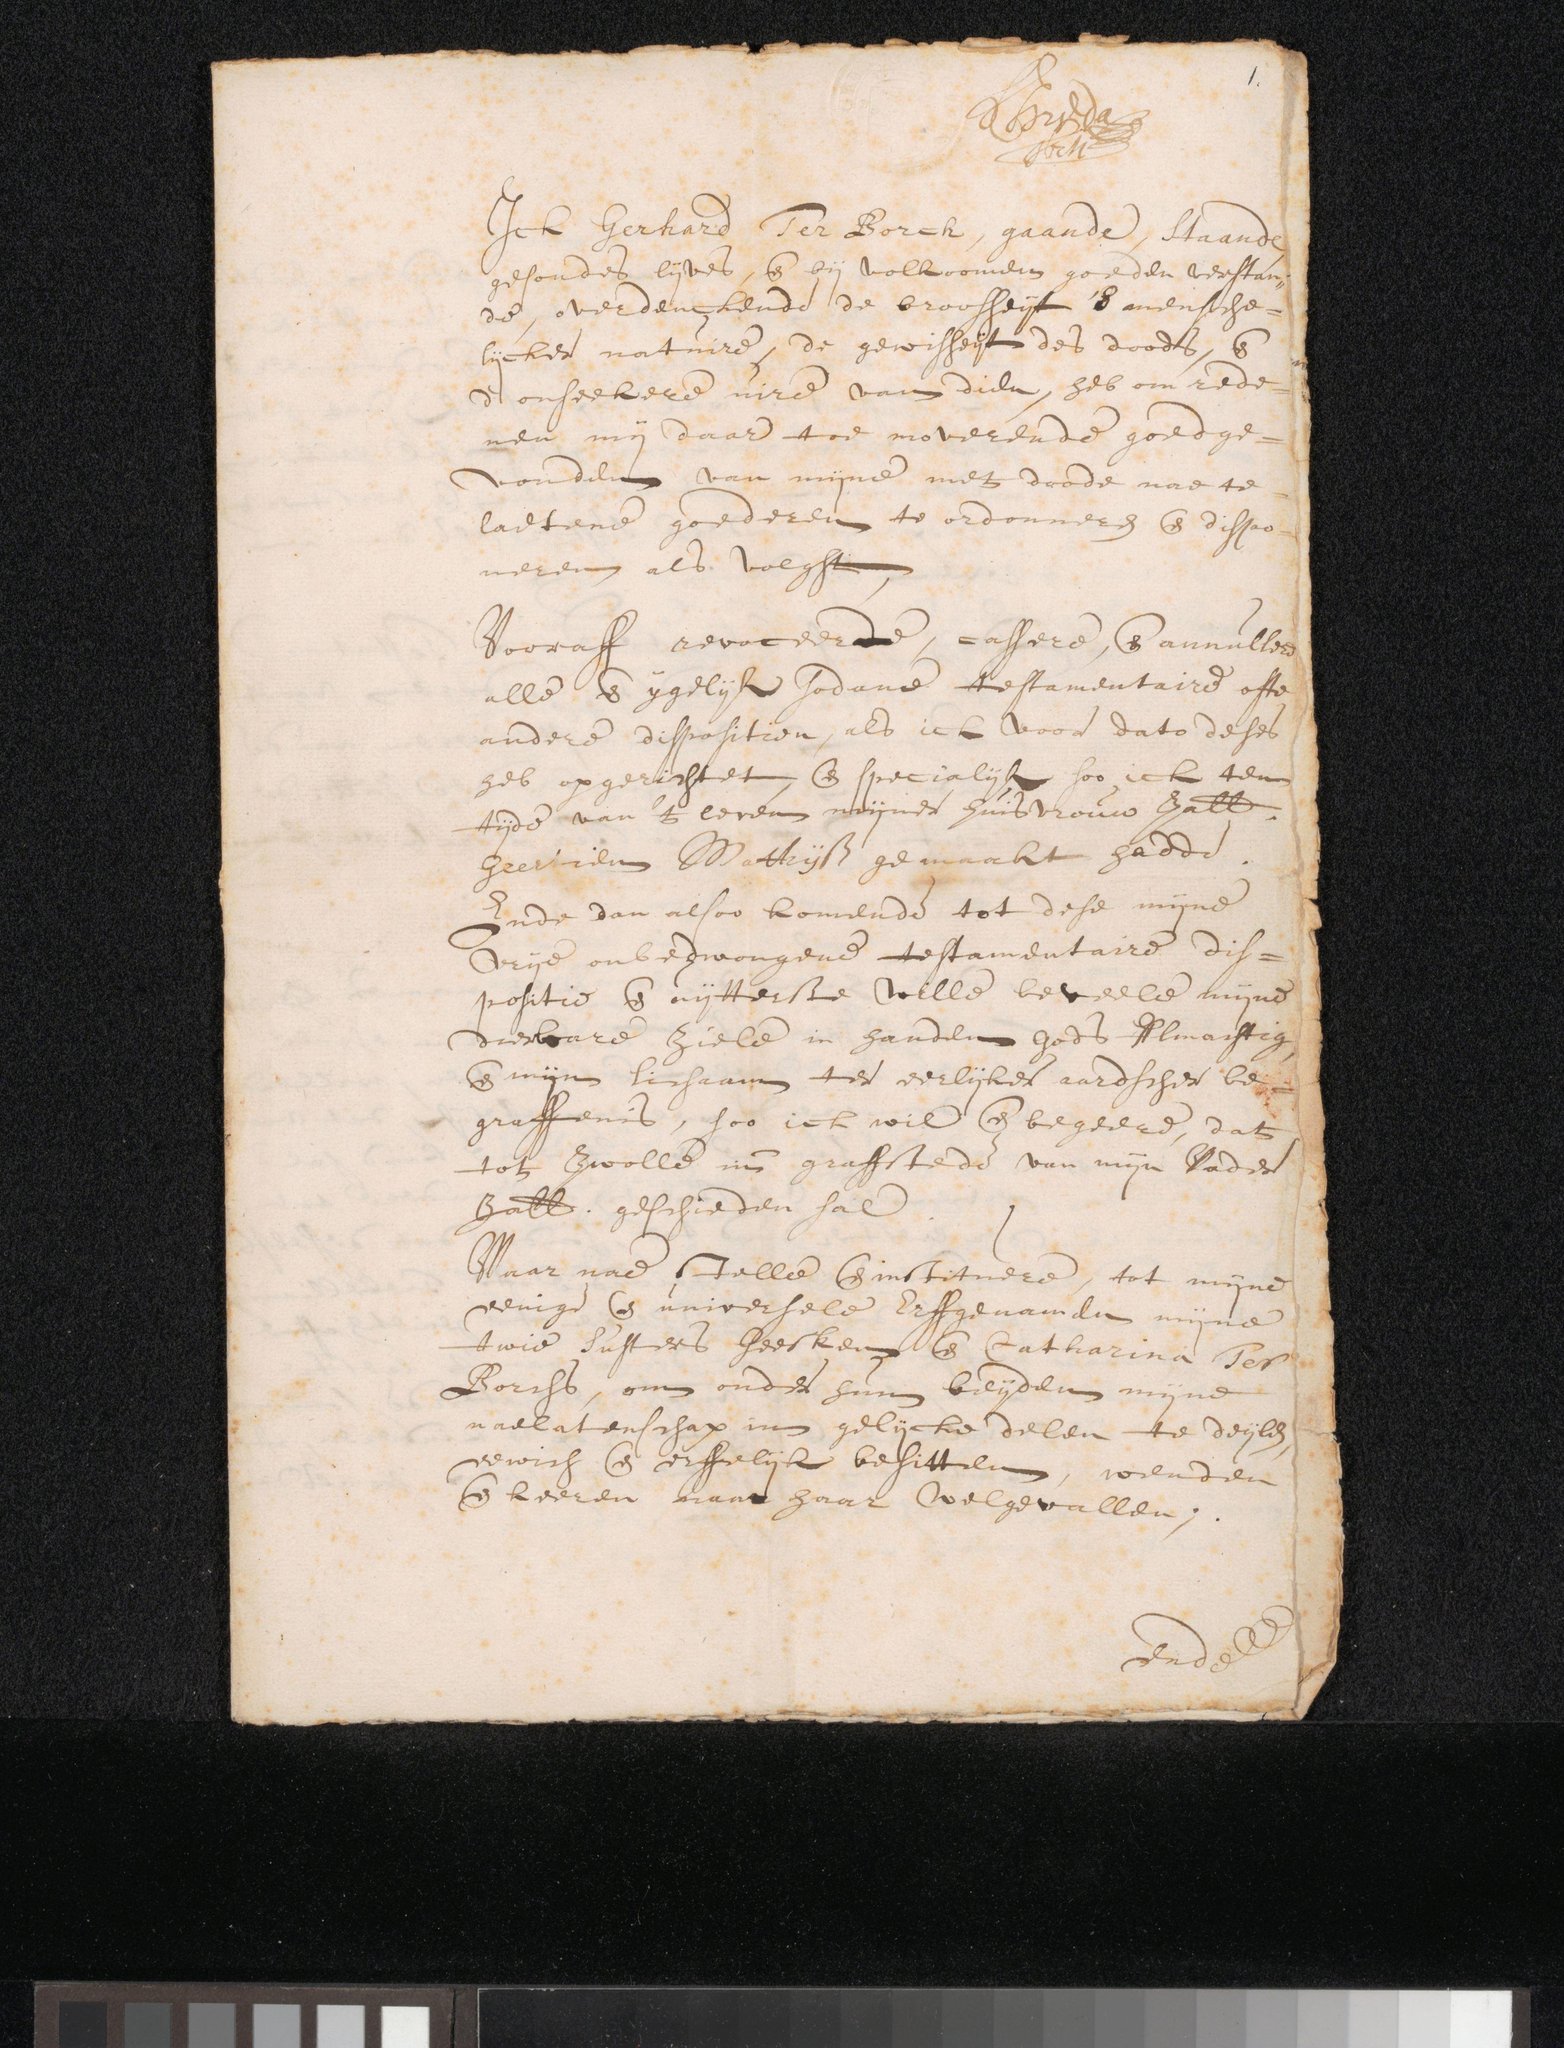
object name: will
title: Testament van Gerard ter Borch (II)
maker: gerard ter borch (ii)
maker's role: draughtsman, painter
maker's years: 1617-1681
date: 1681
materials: ink, paper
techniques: pen, writing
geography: deventer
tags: catharina ter borch, deventer, draughtsman, gesina ter borch, harmen ter borch, gerard ter borch (ii), family life, money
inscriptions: watermark